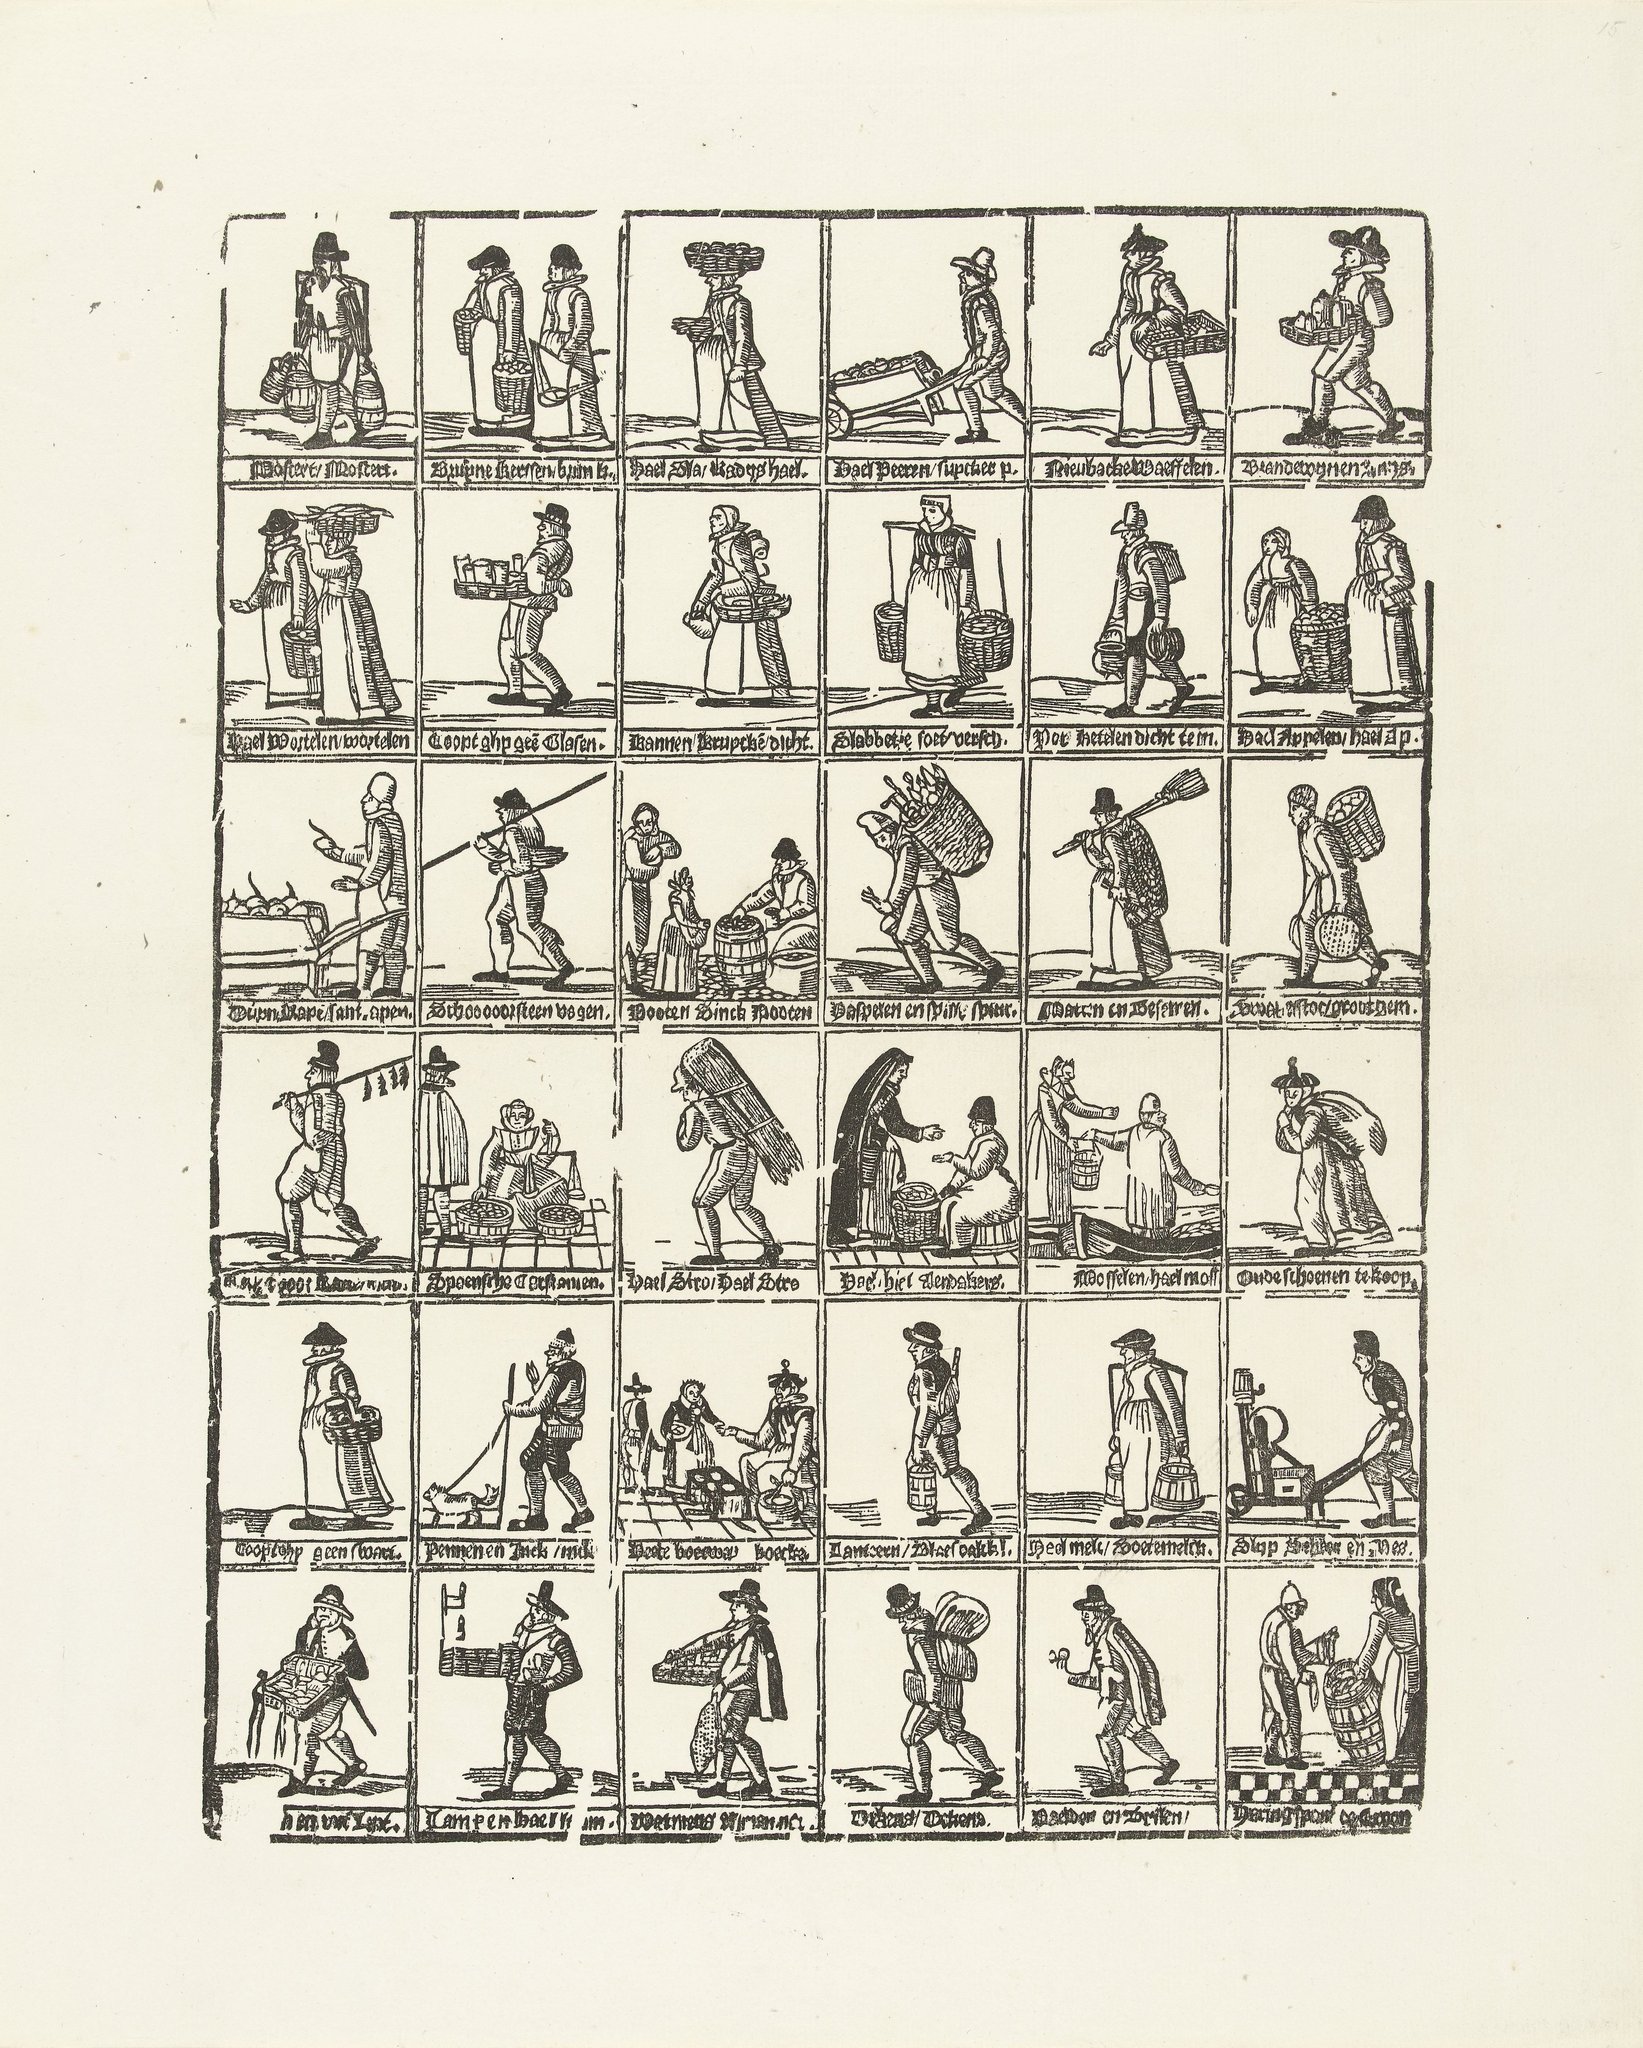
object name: popular print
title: Straatroepen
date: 1700-1725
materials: paper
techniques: woodcut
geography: ghent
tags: 'cris de paris', cries of london, etc.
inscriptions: collector's mark: Lugt 2760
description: Blad met 36 voorstellingen van straathandelaren met hun roepen. Onder elk plaatje de roep in het onderschrift in gotische letters.